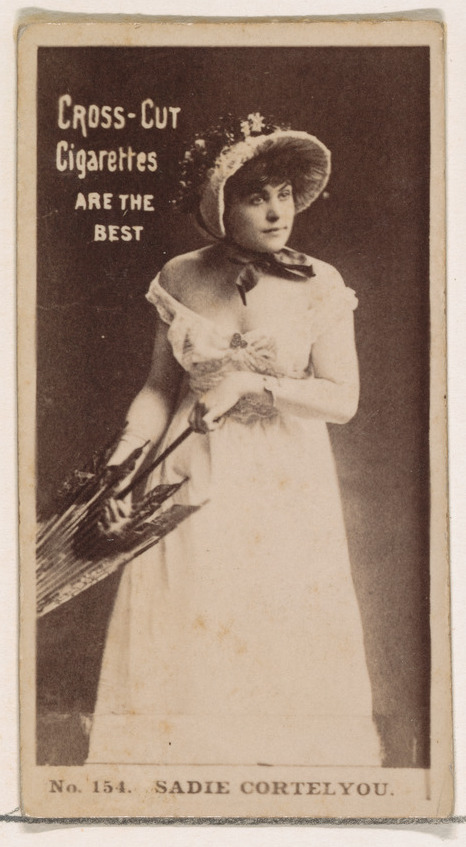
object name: print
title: Card Number 154, Sadie Cortelyou, from the Actors and Actresses series (N145-2) issued by Duke Sons & Co. to promote Cross Cut Cigarettes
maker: w. duke, sons & co.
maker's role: publisher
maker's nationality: american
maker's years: 1870-1920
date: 1880-1889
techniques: albumen silver print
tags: portraits,women,actresses